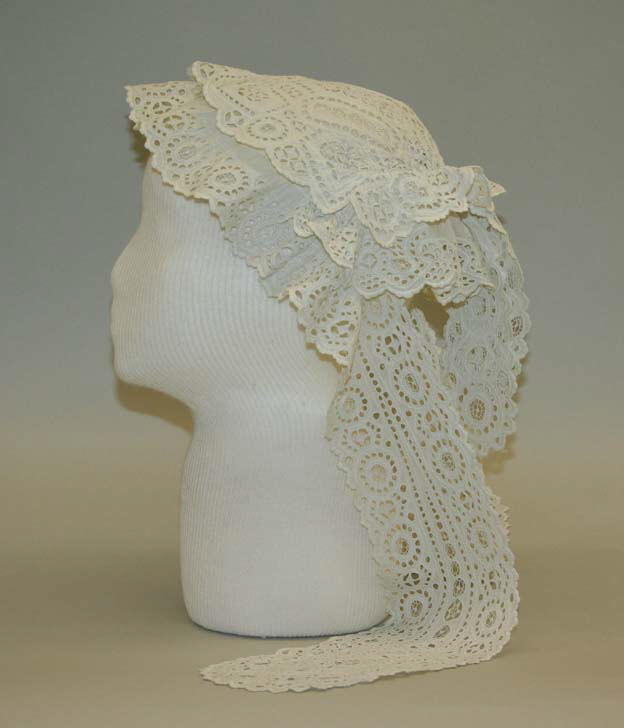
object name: cap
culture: american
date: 1801-1833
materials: cotton